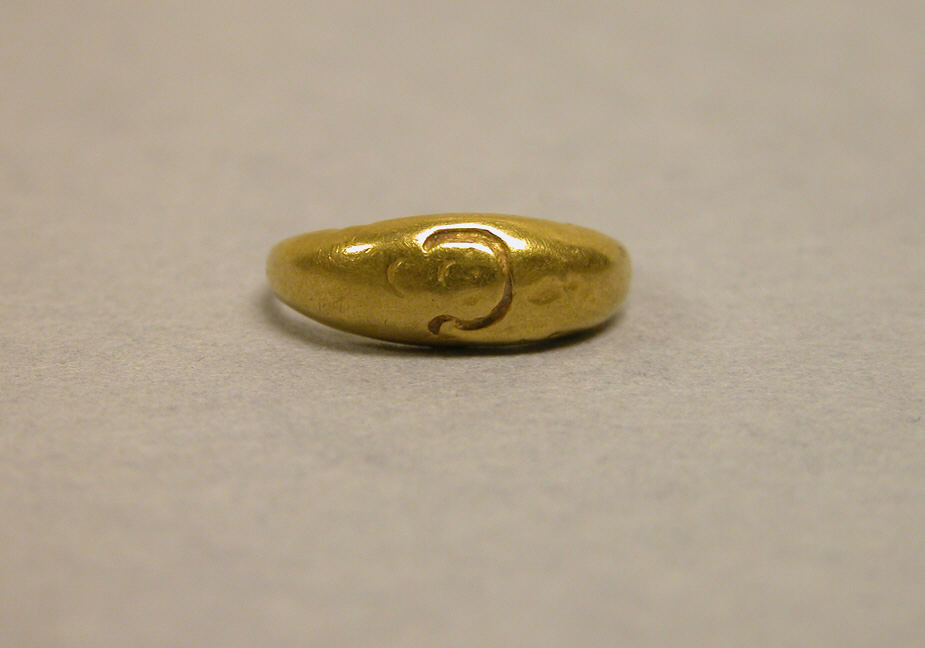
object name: ring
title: Engraved Ring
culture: indonesian, central java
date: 701-1200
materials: gold